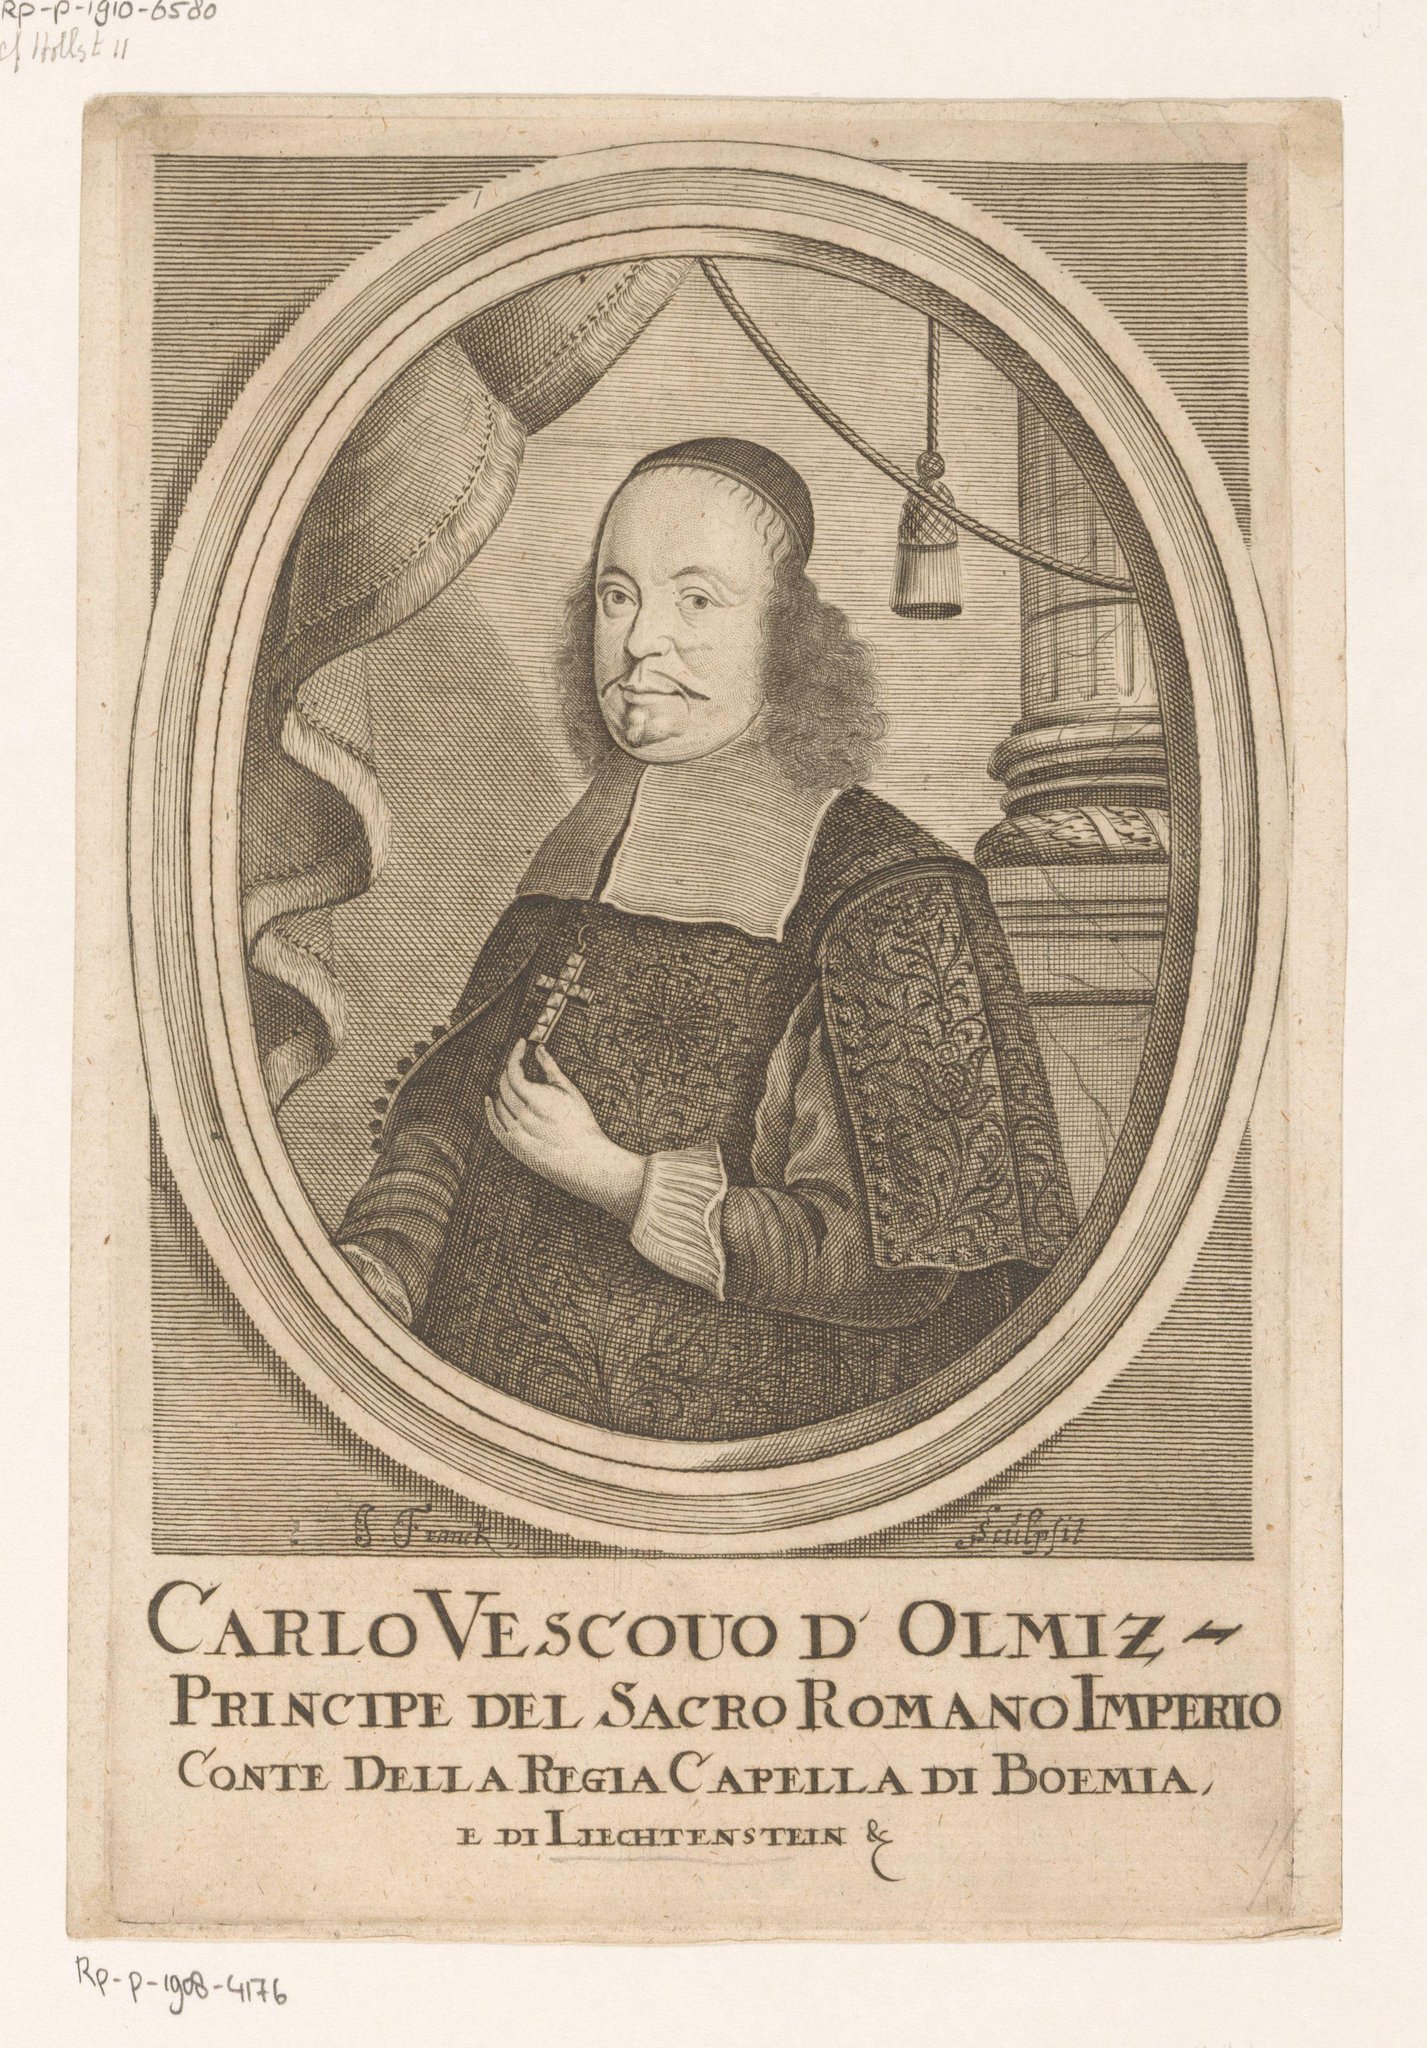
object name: print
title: Portret van Karel van Liechtenstein-Castelcorn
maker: johann franck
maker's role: print maker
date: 1670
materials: paper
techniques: engraving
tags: historical persons, crucifix ~ personal devotion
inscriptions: collector's mark: Lugt 2228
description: Prent gebruikt voor: Priorato, Galeazzo Gualdo. Historia di Leopoldo cesare continente le cose piu memorabili successe in Europa dal 1656 sino al 1670. Wenen: Johann Baptist Hacque, 1670.